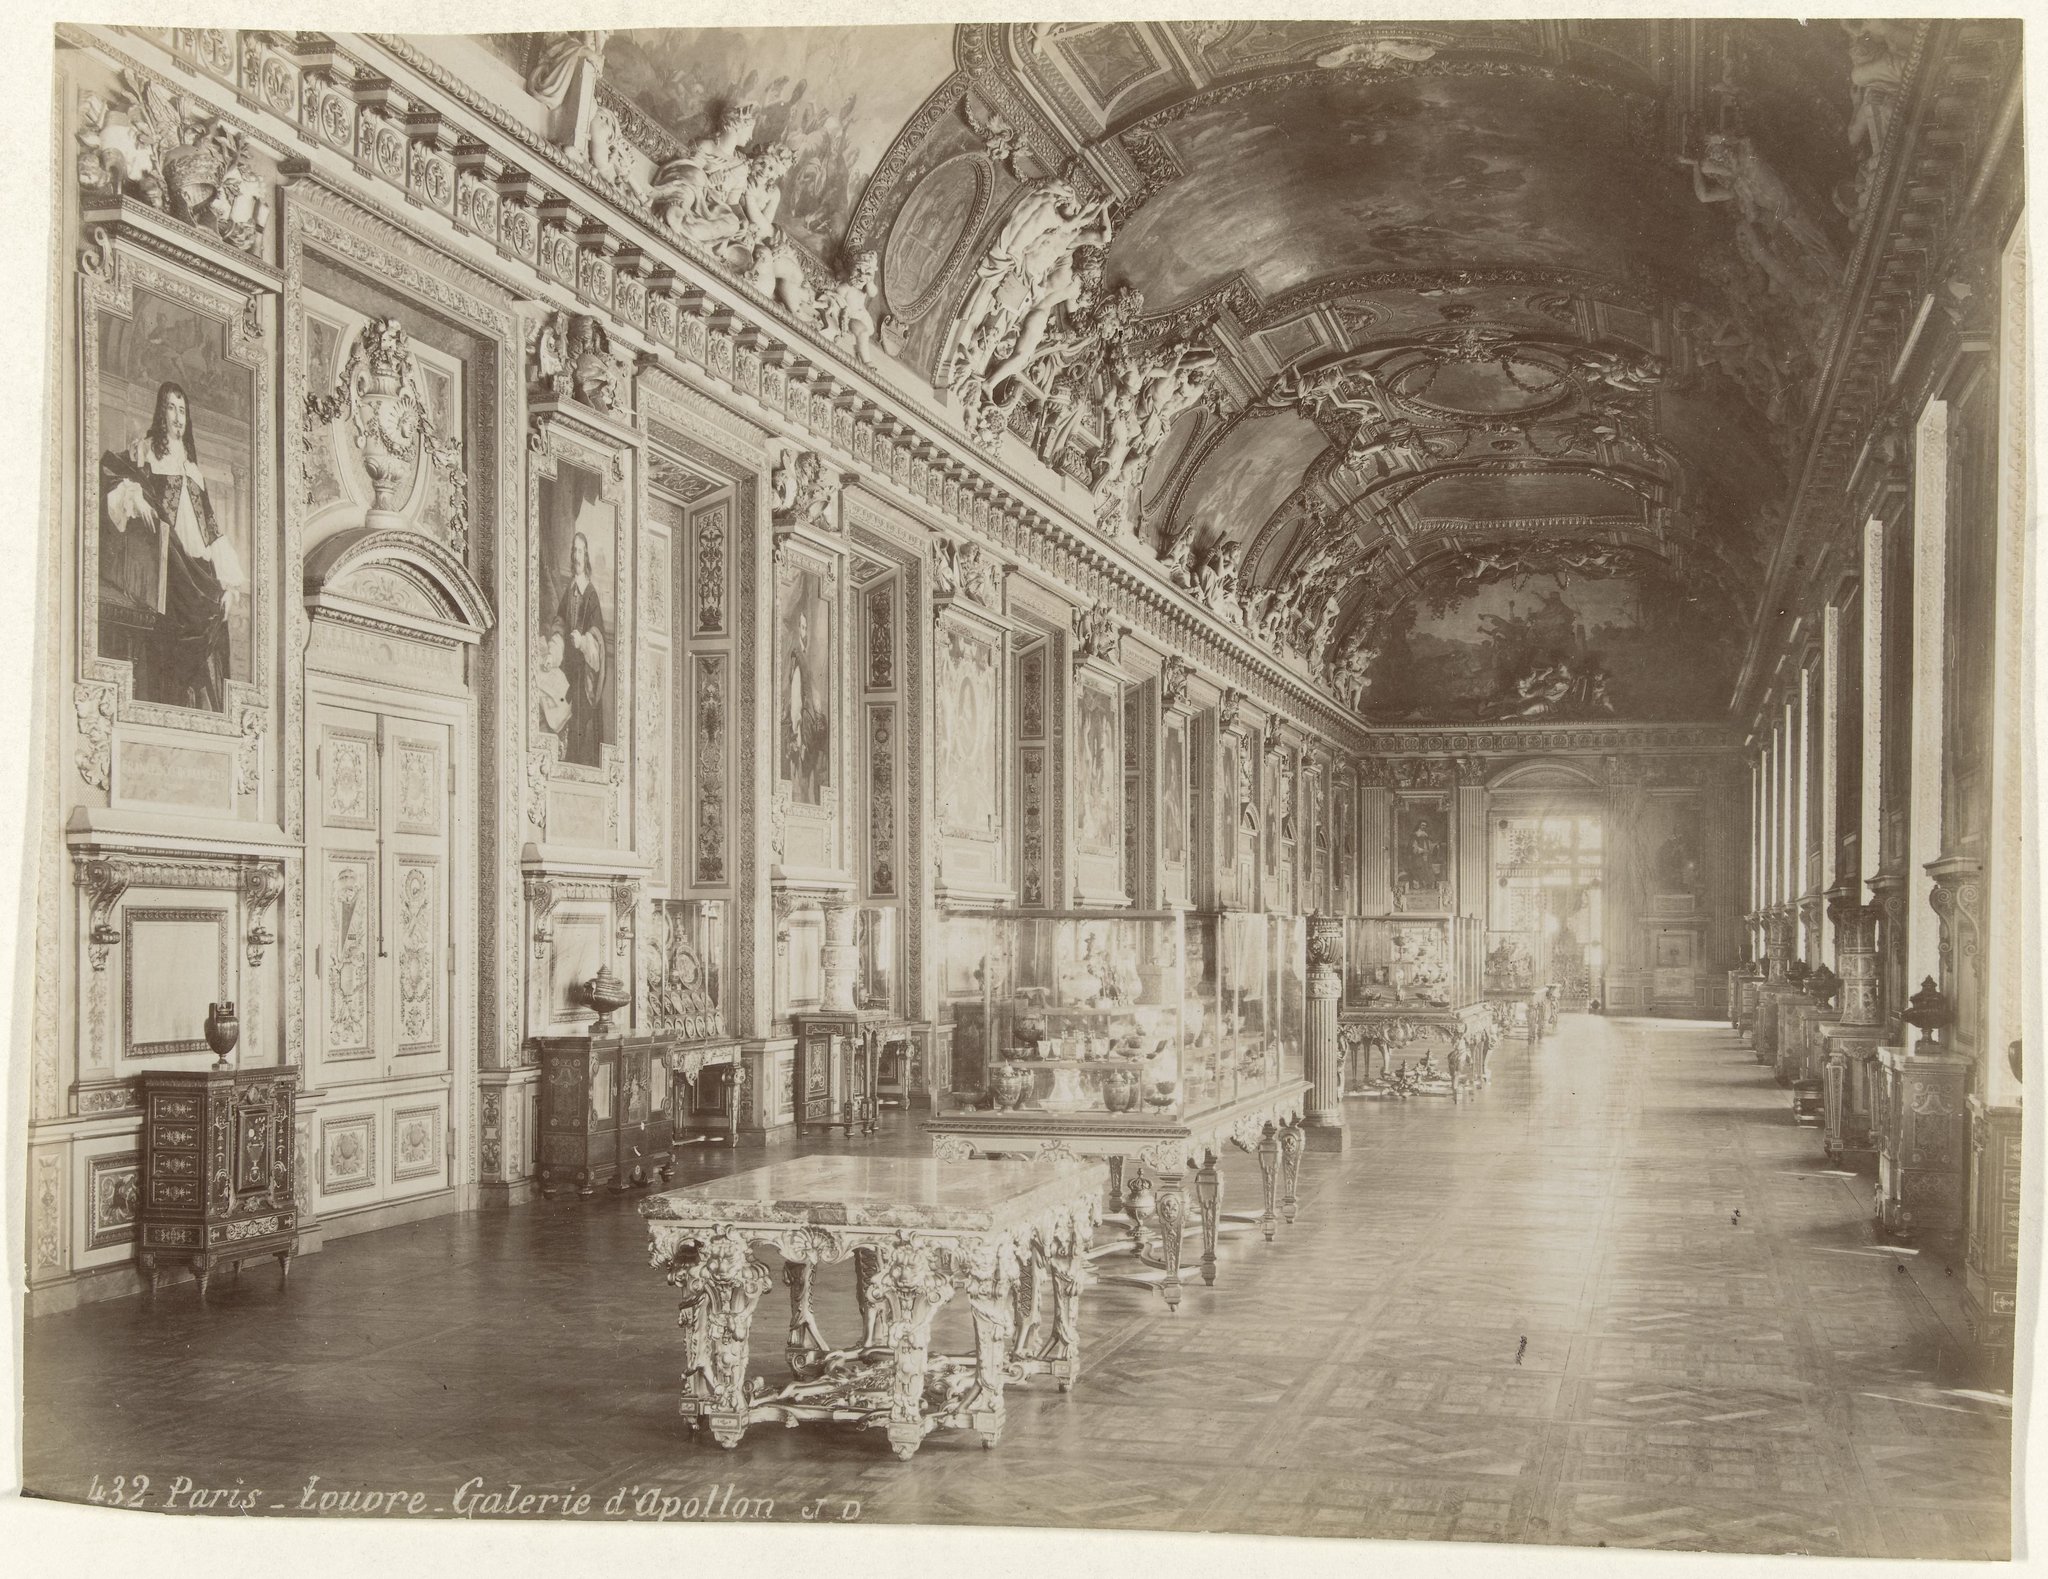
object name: photograph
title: Paris - Louvre. Galerie d'Apollon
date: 1870-1910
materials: cardboard, paper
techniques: albumen print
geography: paris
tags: gallery (spacious corridor), permanent exhibition, museum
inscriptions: inscription: ‘432 Paris - Louvre. Galerie d'Apollon J.D.’, number: ‘14’, stamp: ‘J. Réségotti/ Editeur/ 8, Rue Vivienne/ Paris’